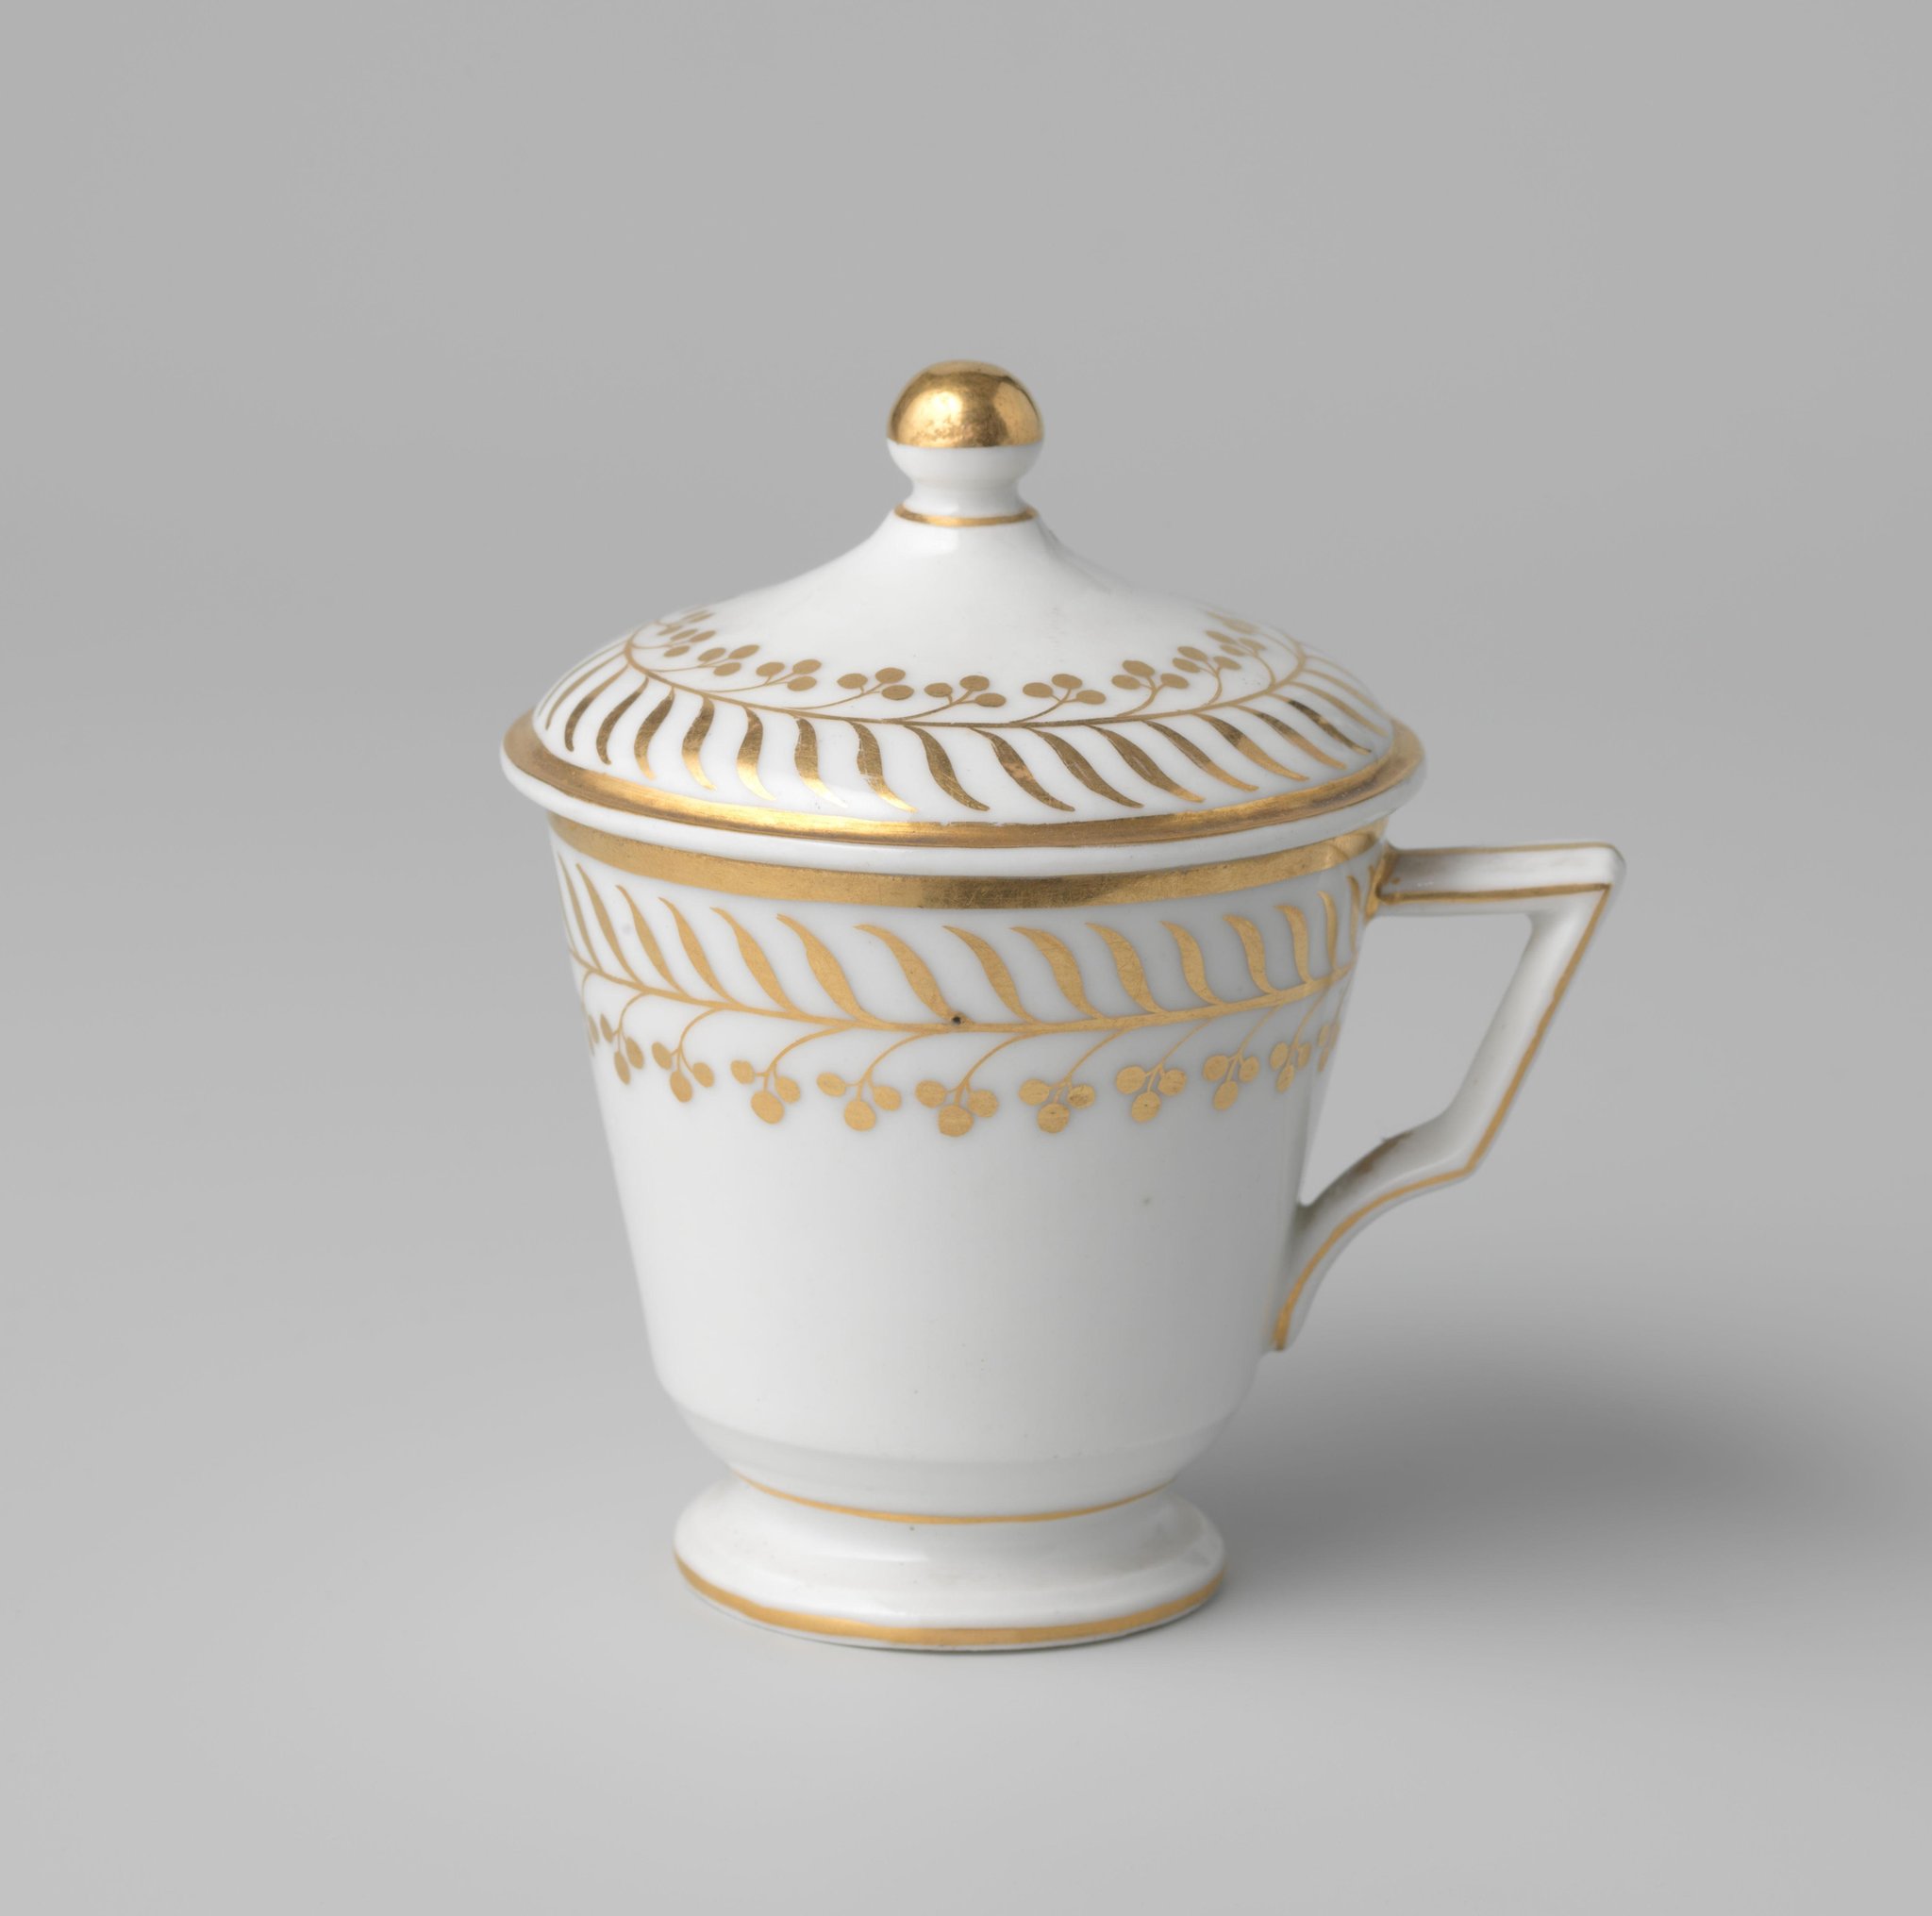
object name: covered cup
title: Covered cup (pot de crème) with stylized floral scrolls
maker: Anonymous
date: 1800-1810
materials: glaze, gold, paint, porcelain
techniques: firing, forming, gilding, vitrification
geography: france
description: Crêmepot van porselein, met oor en deksel waarop een vergulde knop. Versierd met gouden biezen en langs de randen beschilderd met een doorlopende tak met aan de ene zijde bladeren, aan de andere zijde steeds een tak met drie vruchten. Gemerkt met ingegrifte 1.